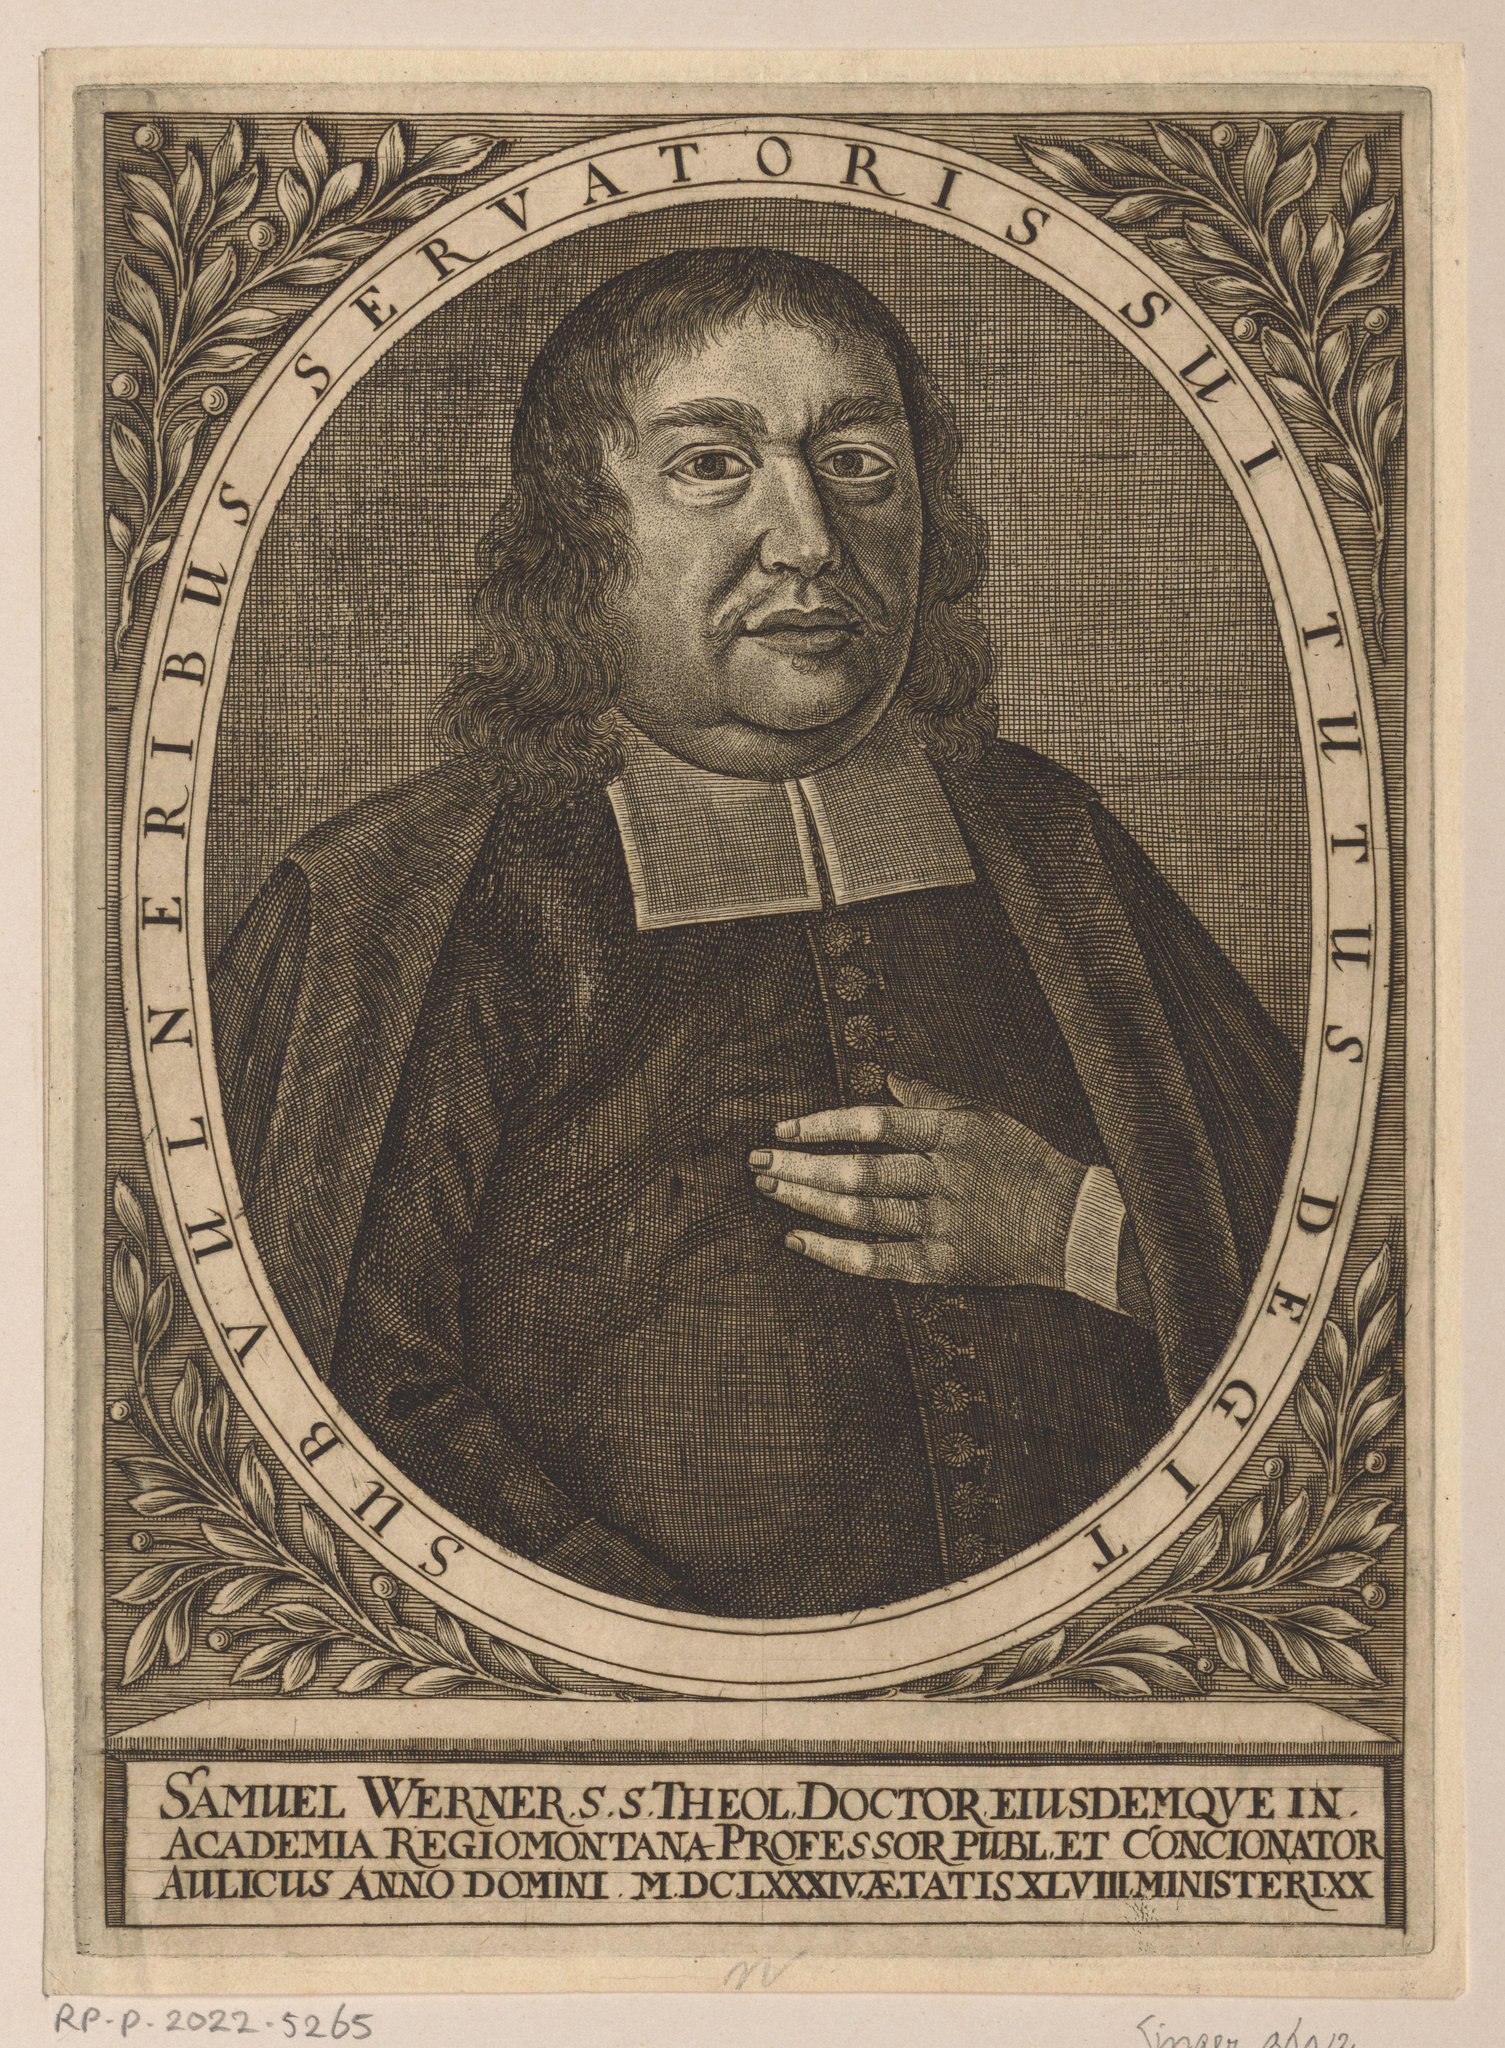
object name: print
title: Portret van Samuel Werner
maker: Anonymous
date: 1684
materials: paper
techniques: engraving, etching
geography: germany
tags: theologian, historical persons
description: Met drieregelig onderschrift in het Latijn.